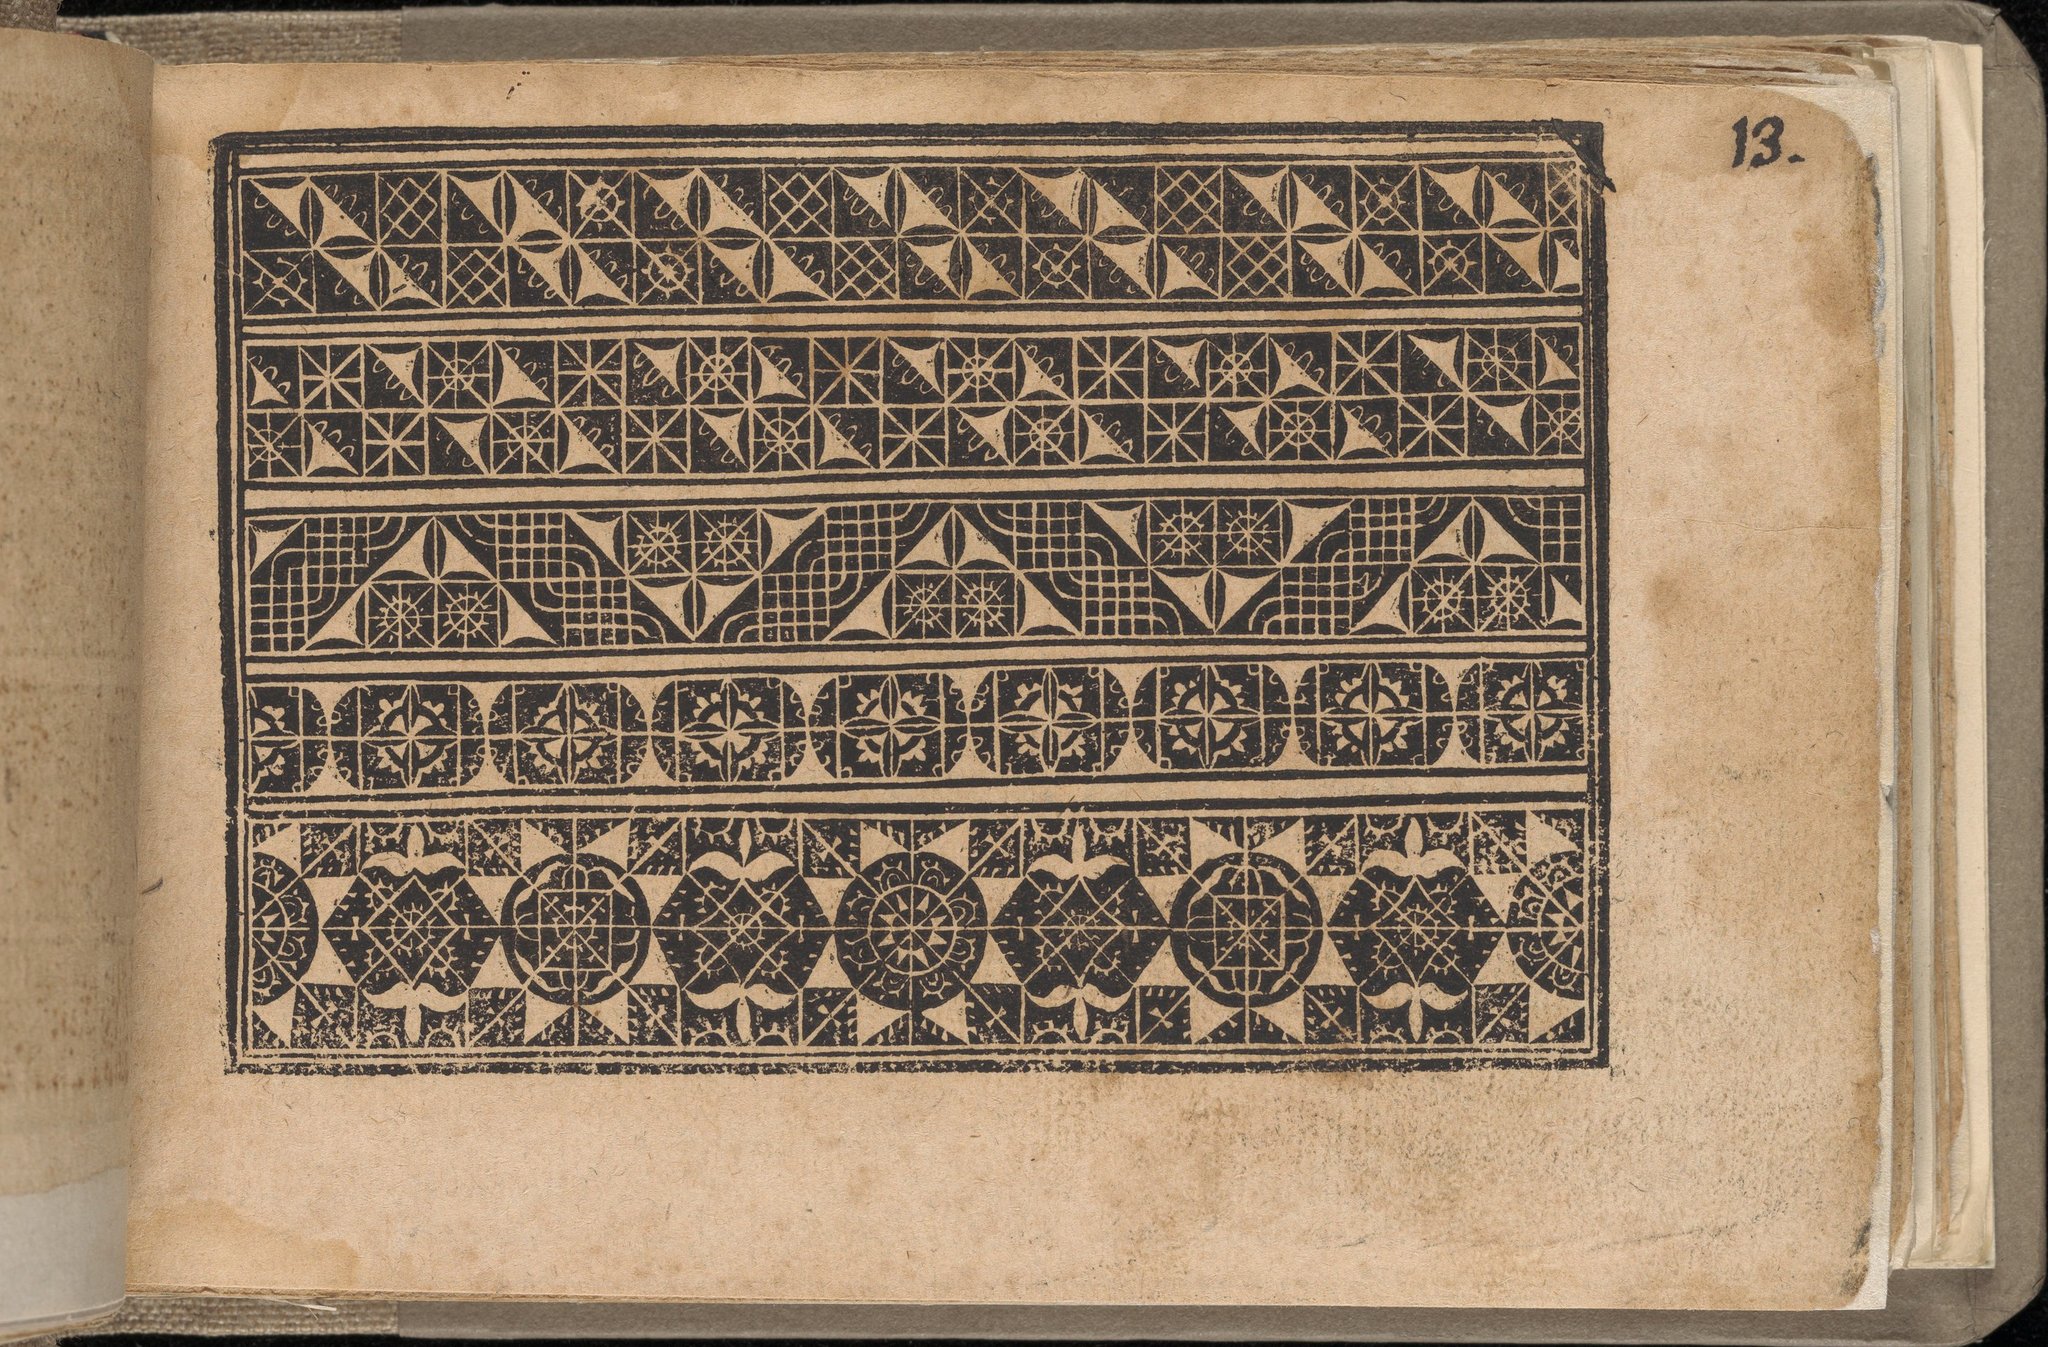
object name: book print ornament architecture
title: Schön newes Modelbuch (Page 13r)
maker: sigismundus latomus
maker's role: publisher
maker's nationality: german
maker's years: 1599-1632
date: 1608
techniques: woodcut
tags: ornament